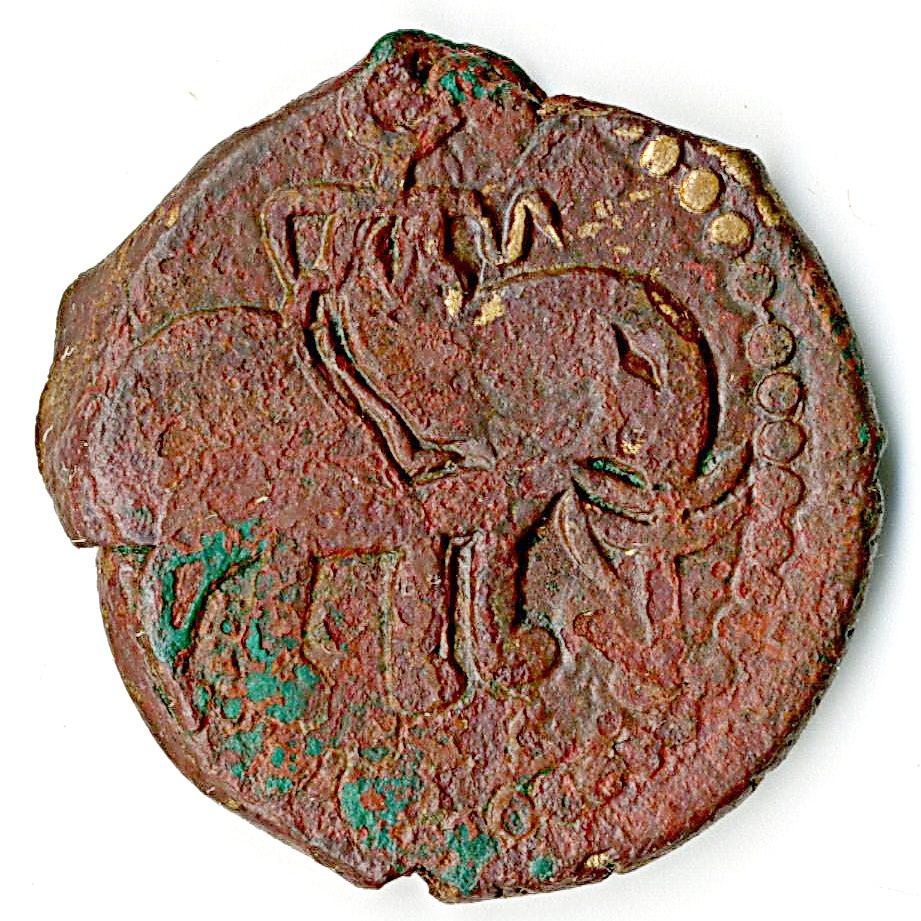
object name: coin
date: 1501-1700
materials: copper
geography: iran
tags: elephants